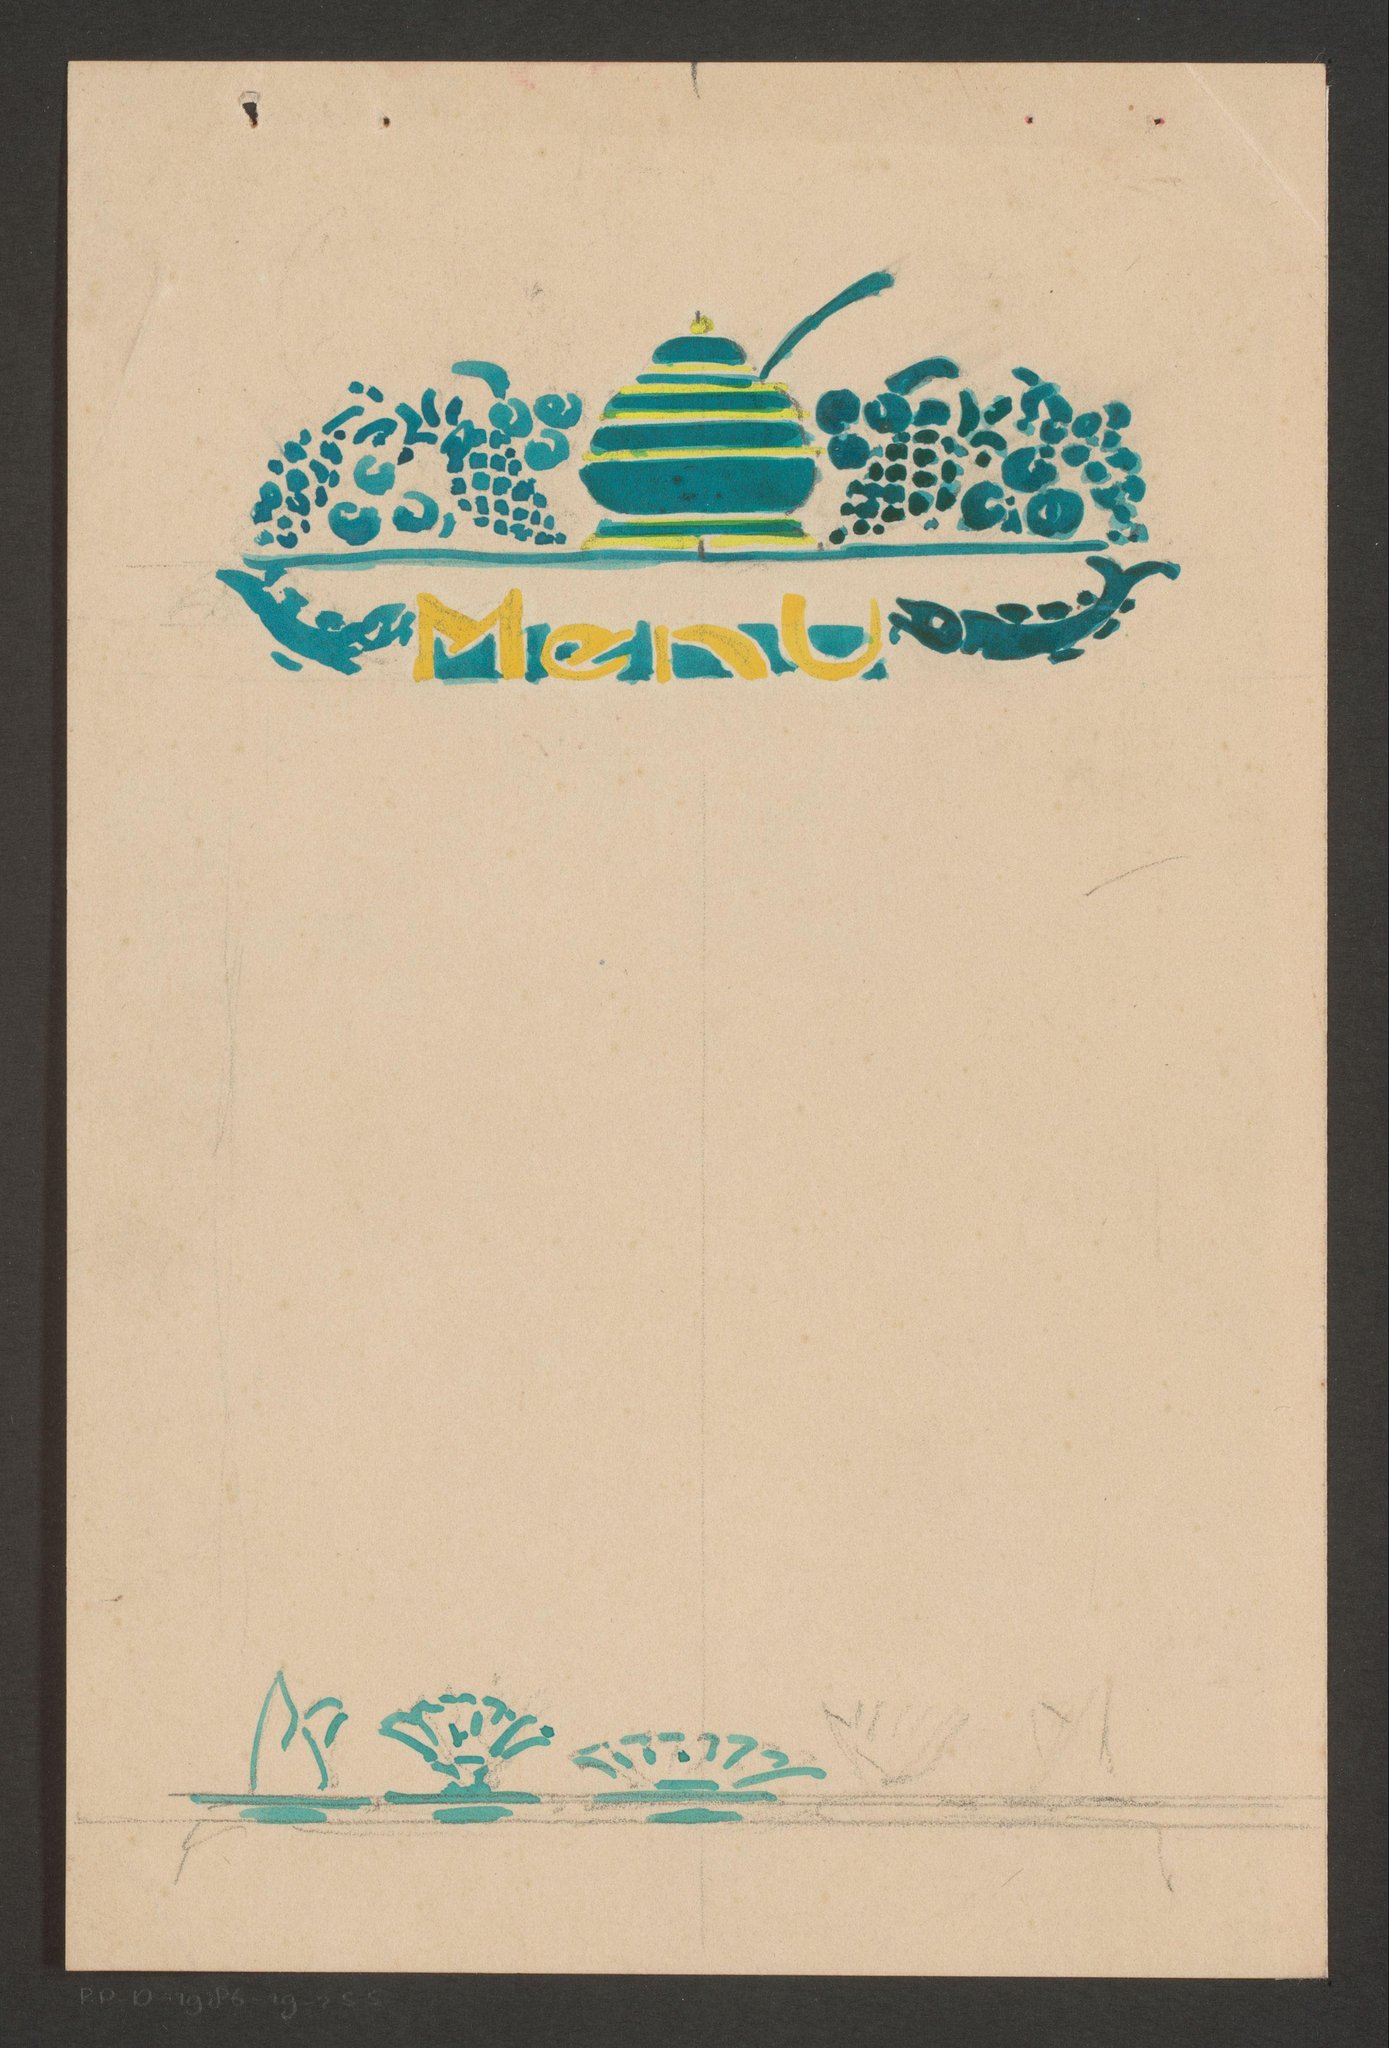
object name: design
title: Ontwerp voor een menukaart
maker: reinier willem petrus de vries (1874-1953)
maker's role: draughtsman, print maker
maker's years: 1874-1953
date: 1884-1952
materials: paper, pencil, watercolor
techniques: brush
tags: vegetables, kitchen-utensils: pot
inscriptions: collector's mark: ‘R:MVS.’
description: Pot met aan weerszijden groente en fruit.